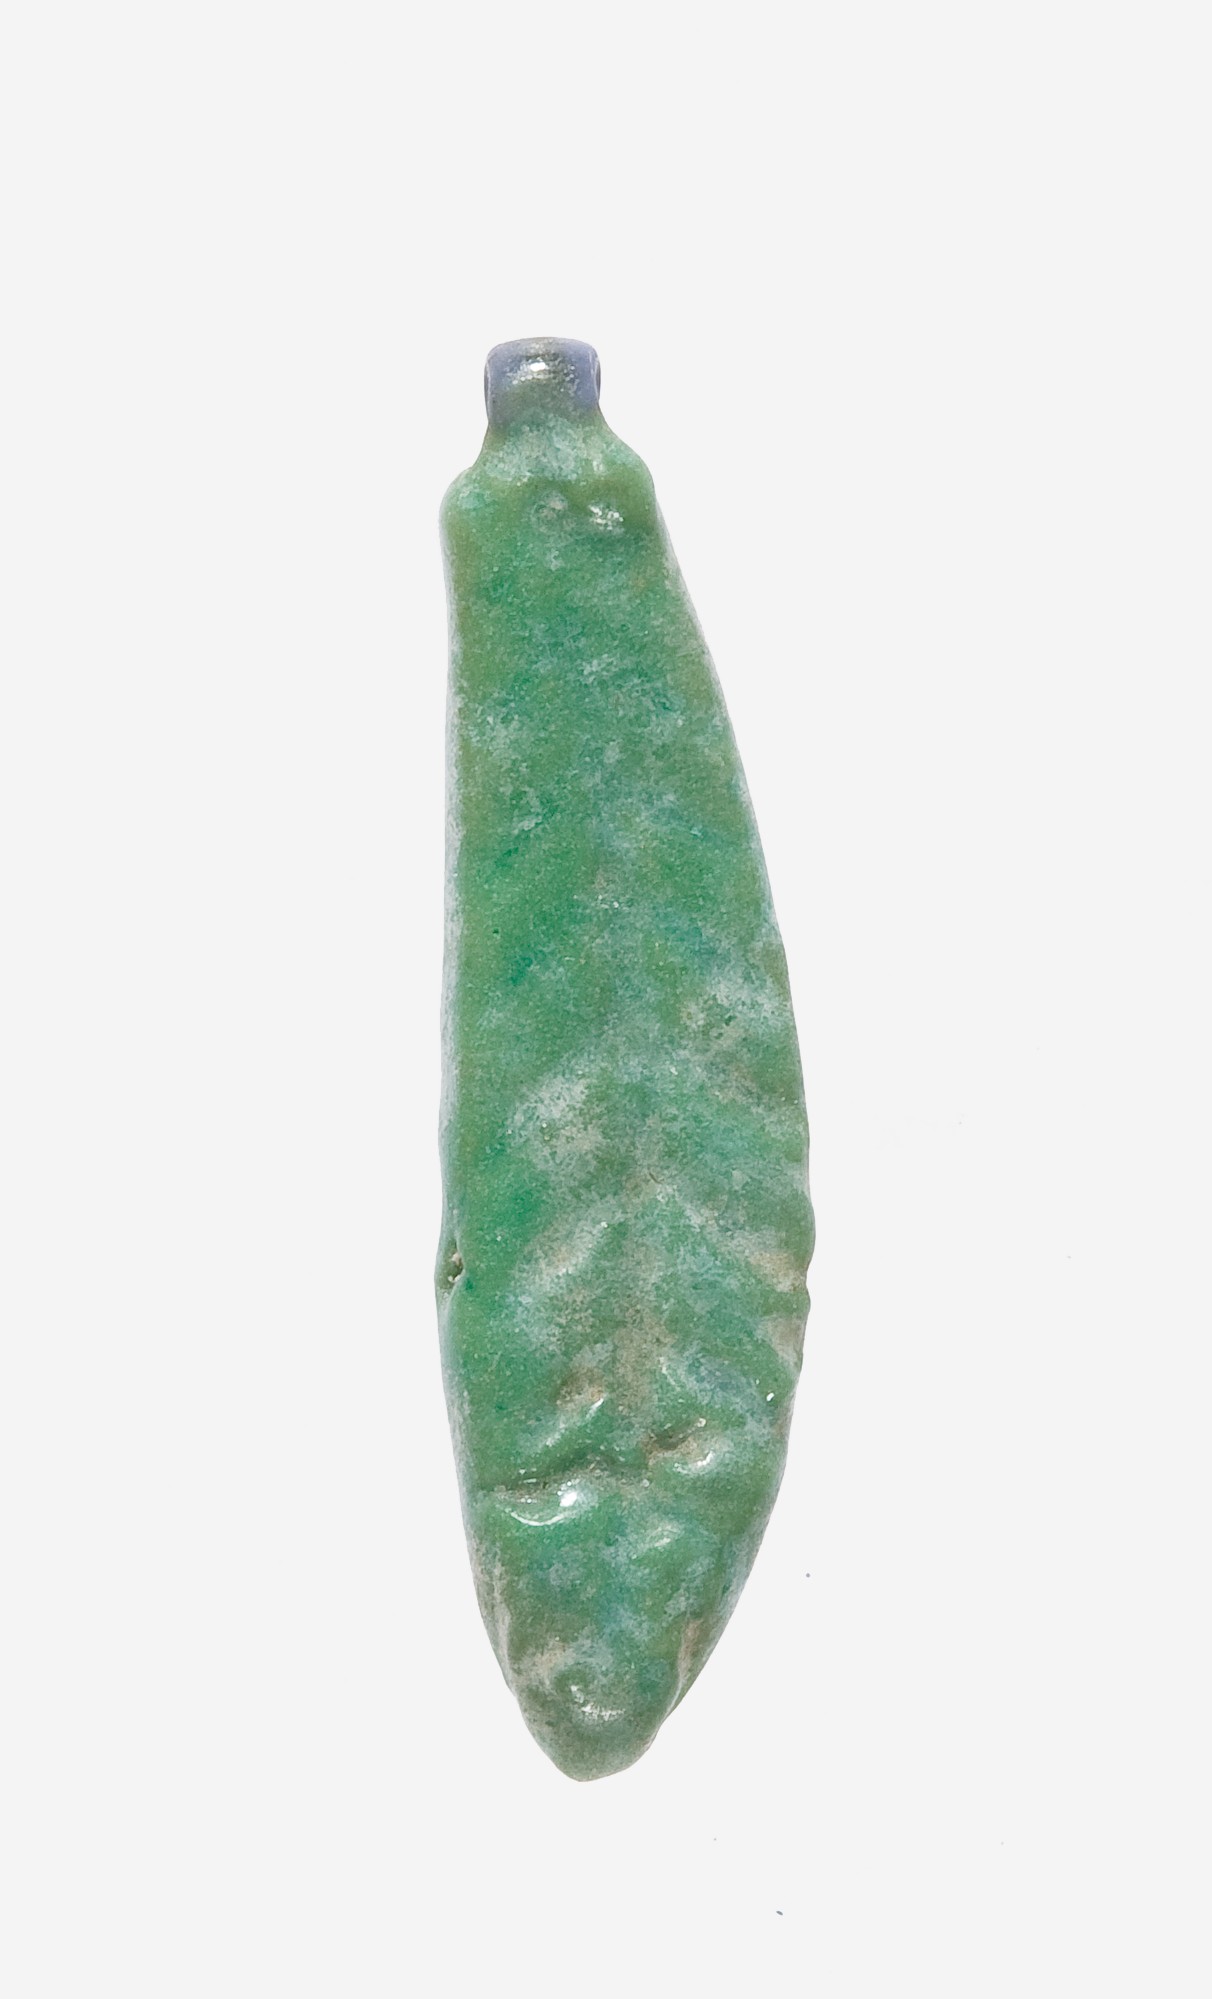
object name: pendant, leaf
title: Leaf Pendant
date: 1390-1352 BCE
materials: faience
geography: egypt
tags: leaves